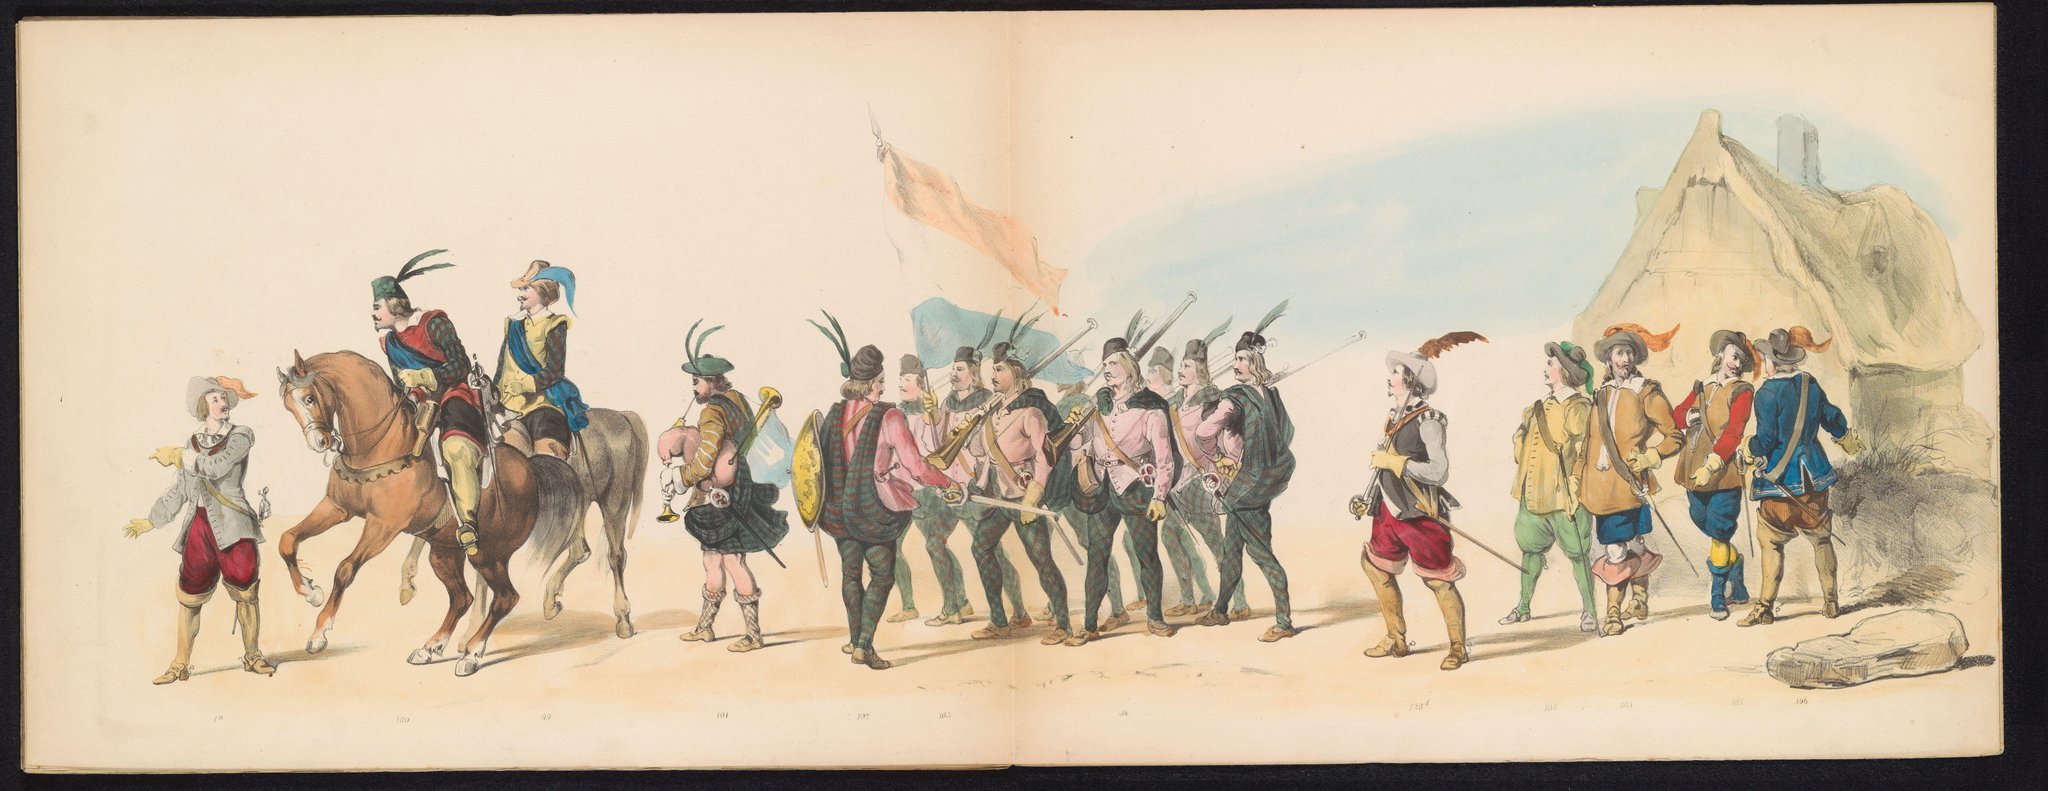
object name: print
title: Intogt van Frederik Hendrik in 's Hertogenbosch in 1629 : gecostumeerde voorstelling door de H.H. studenten der Leydsche Hoogeschool den XI Junij van het jaar 1850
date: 1850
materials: paper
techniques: lithograph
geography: the hague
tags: delft, frederick henry (prince of orange), students' pageant, costumes used in pageants, leiden, den bosch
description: Historische gekostumeerde optocht van de studenten van de Leidse Hogeschool op 11 juni 1850. De optocht verbeeldt de intocht van Frederik Hendrik te Den Bosch in 1629. Elfde plaat met de groepen genummerd 99-108. Onderdeel van de serie van dertien aanelkaar geplakte bladen.